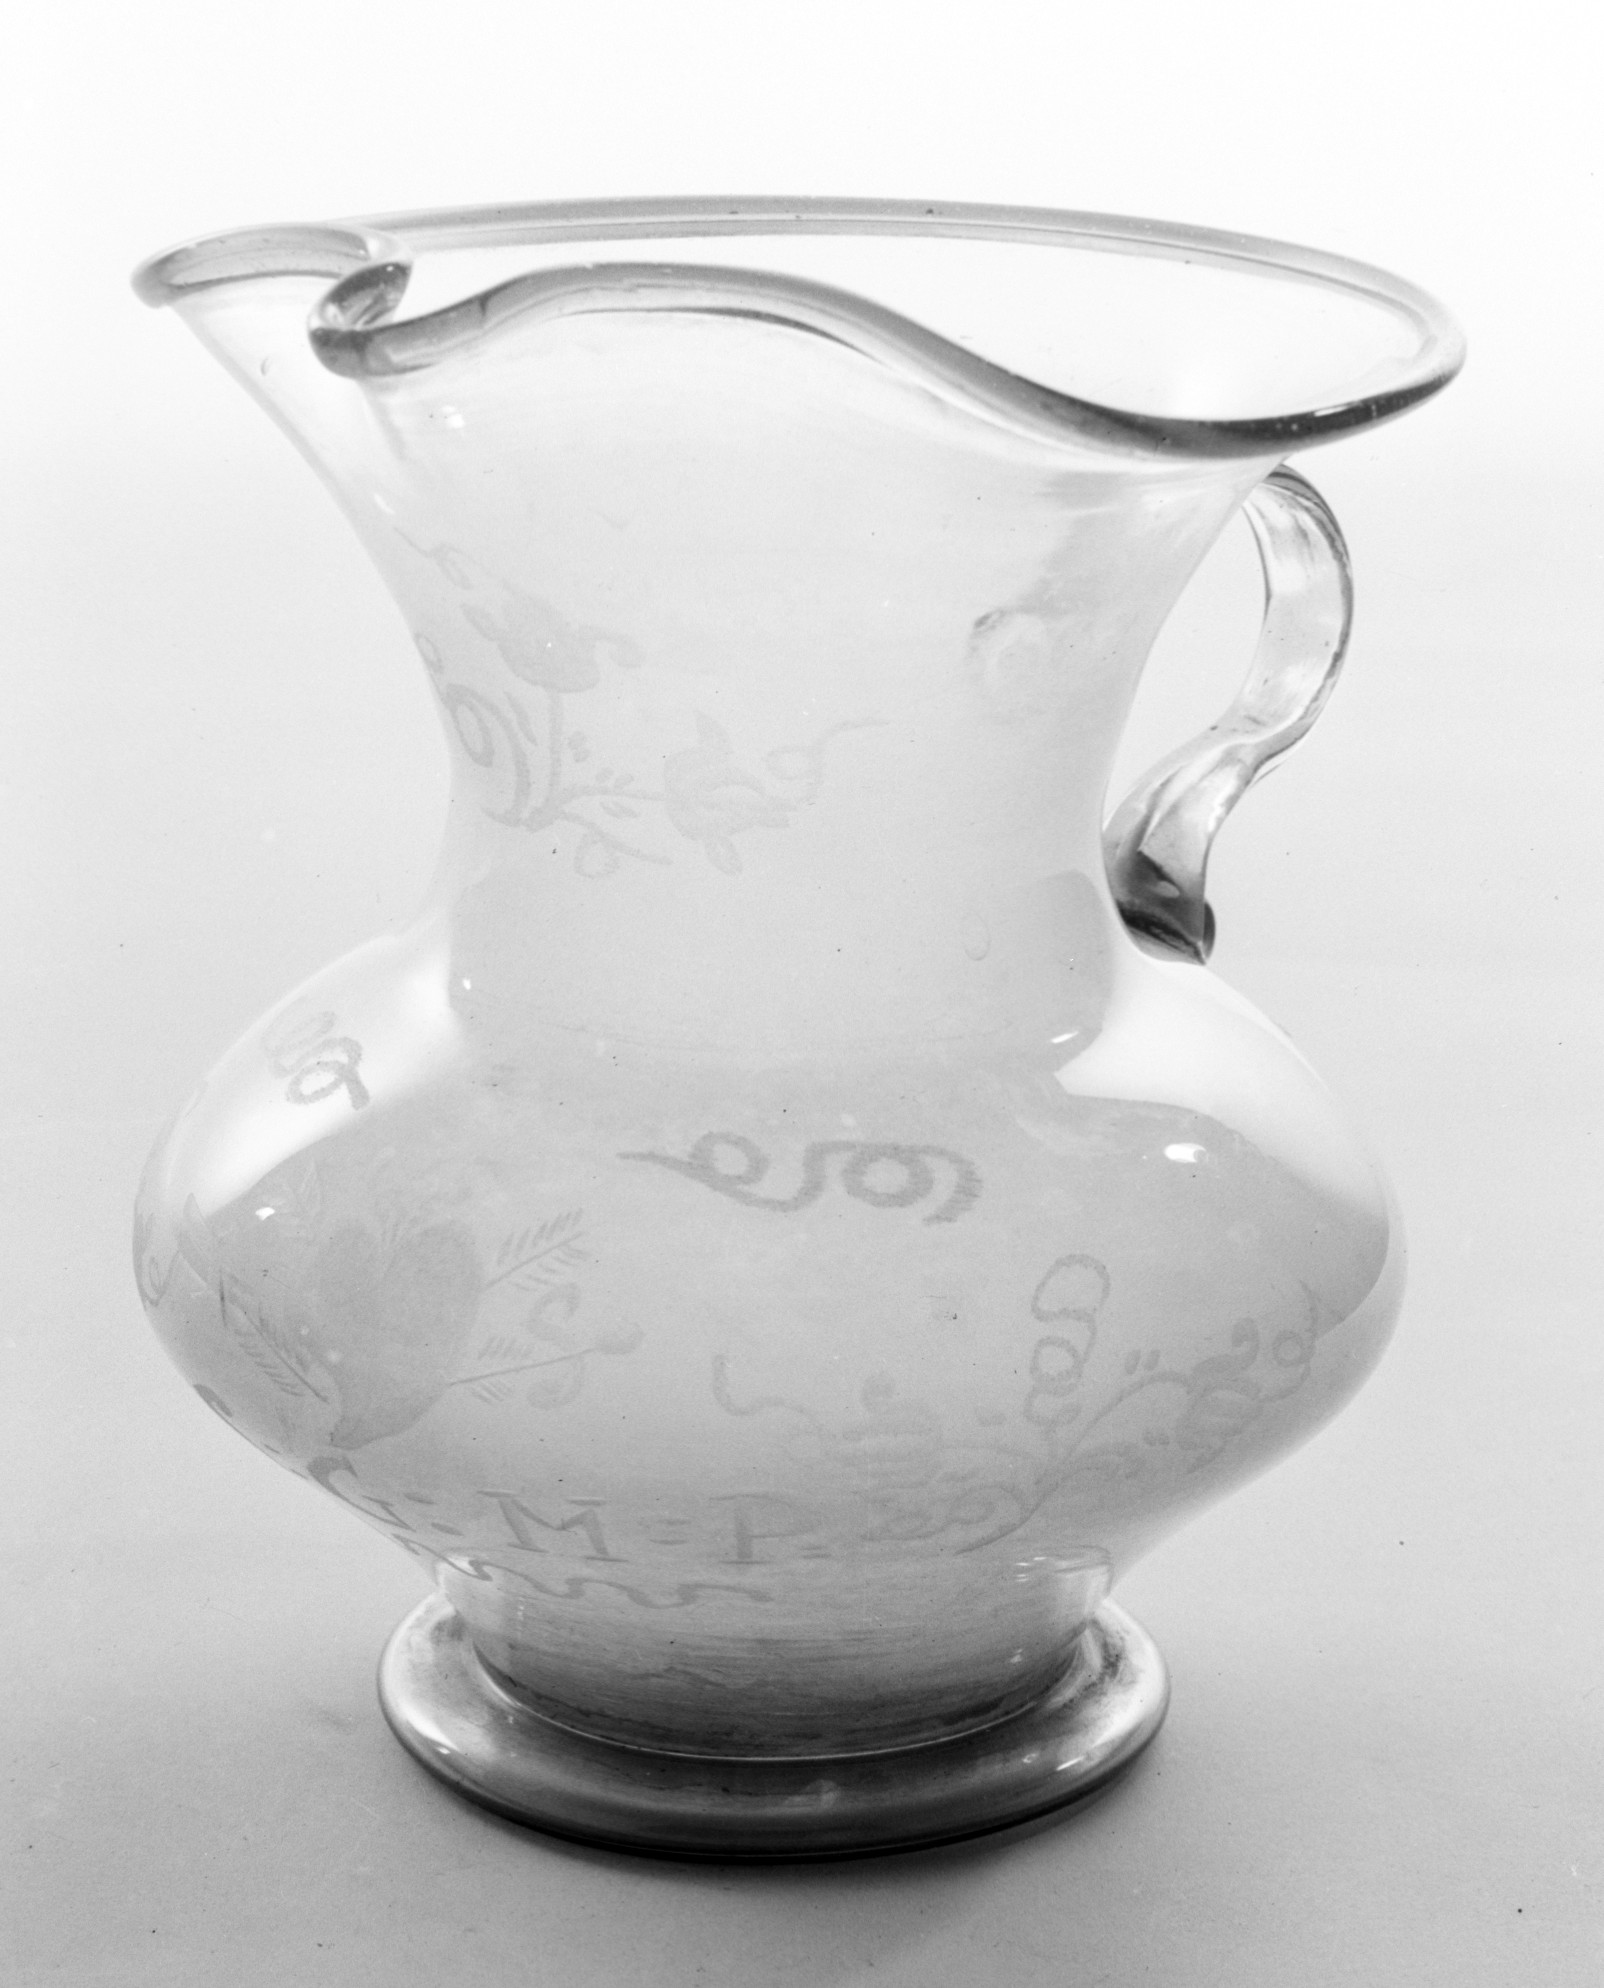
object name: jug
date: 1701-1800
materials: glass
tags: flowers